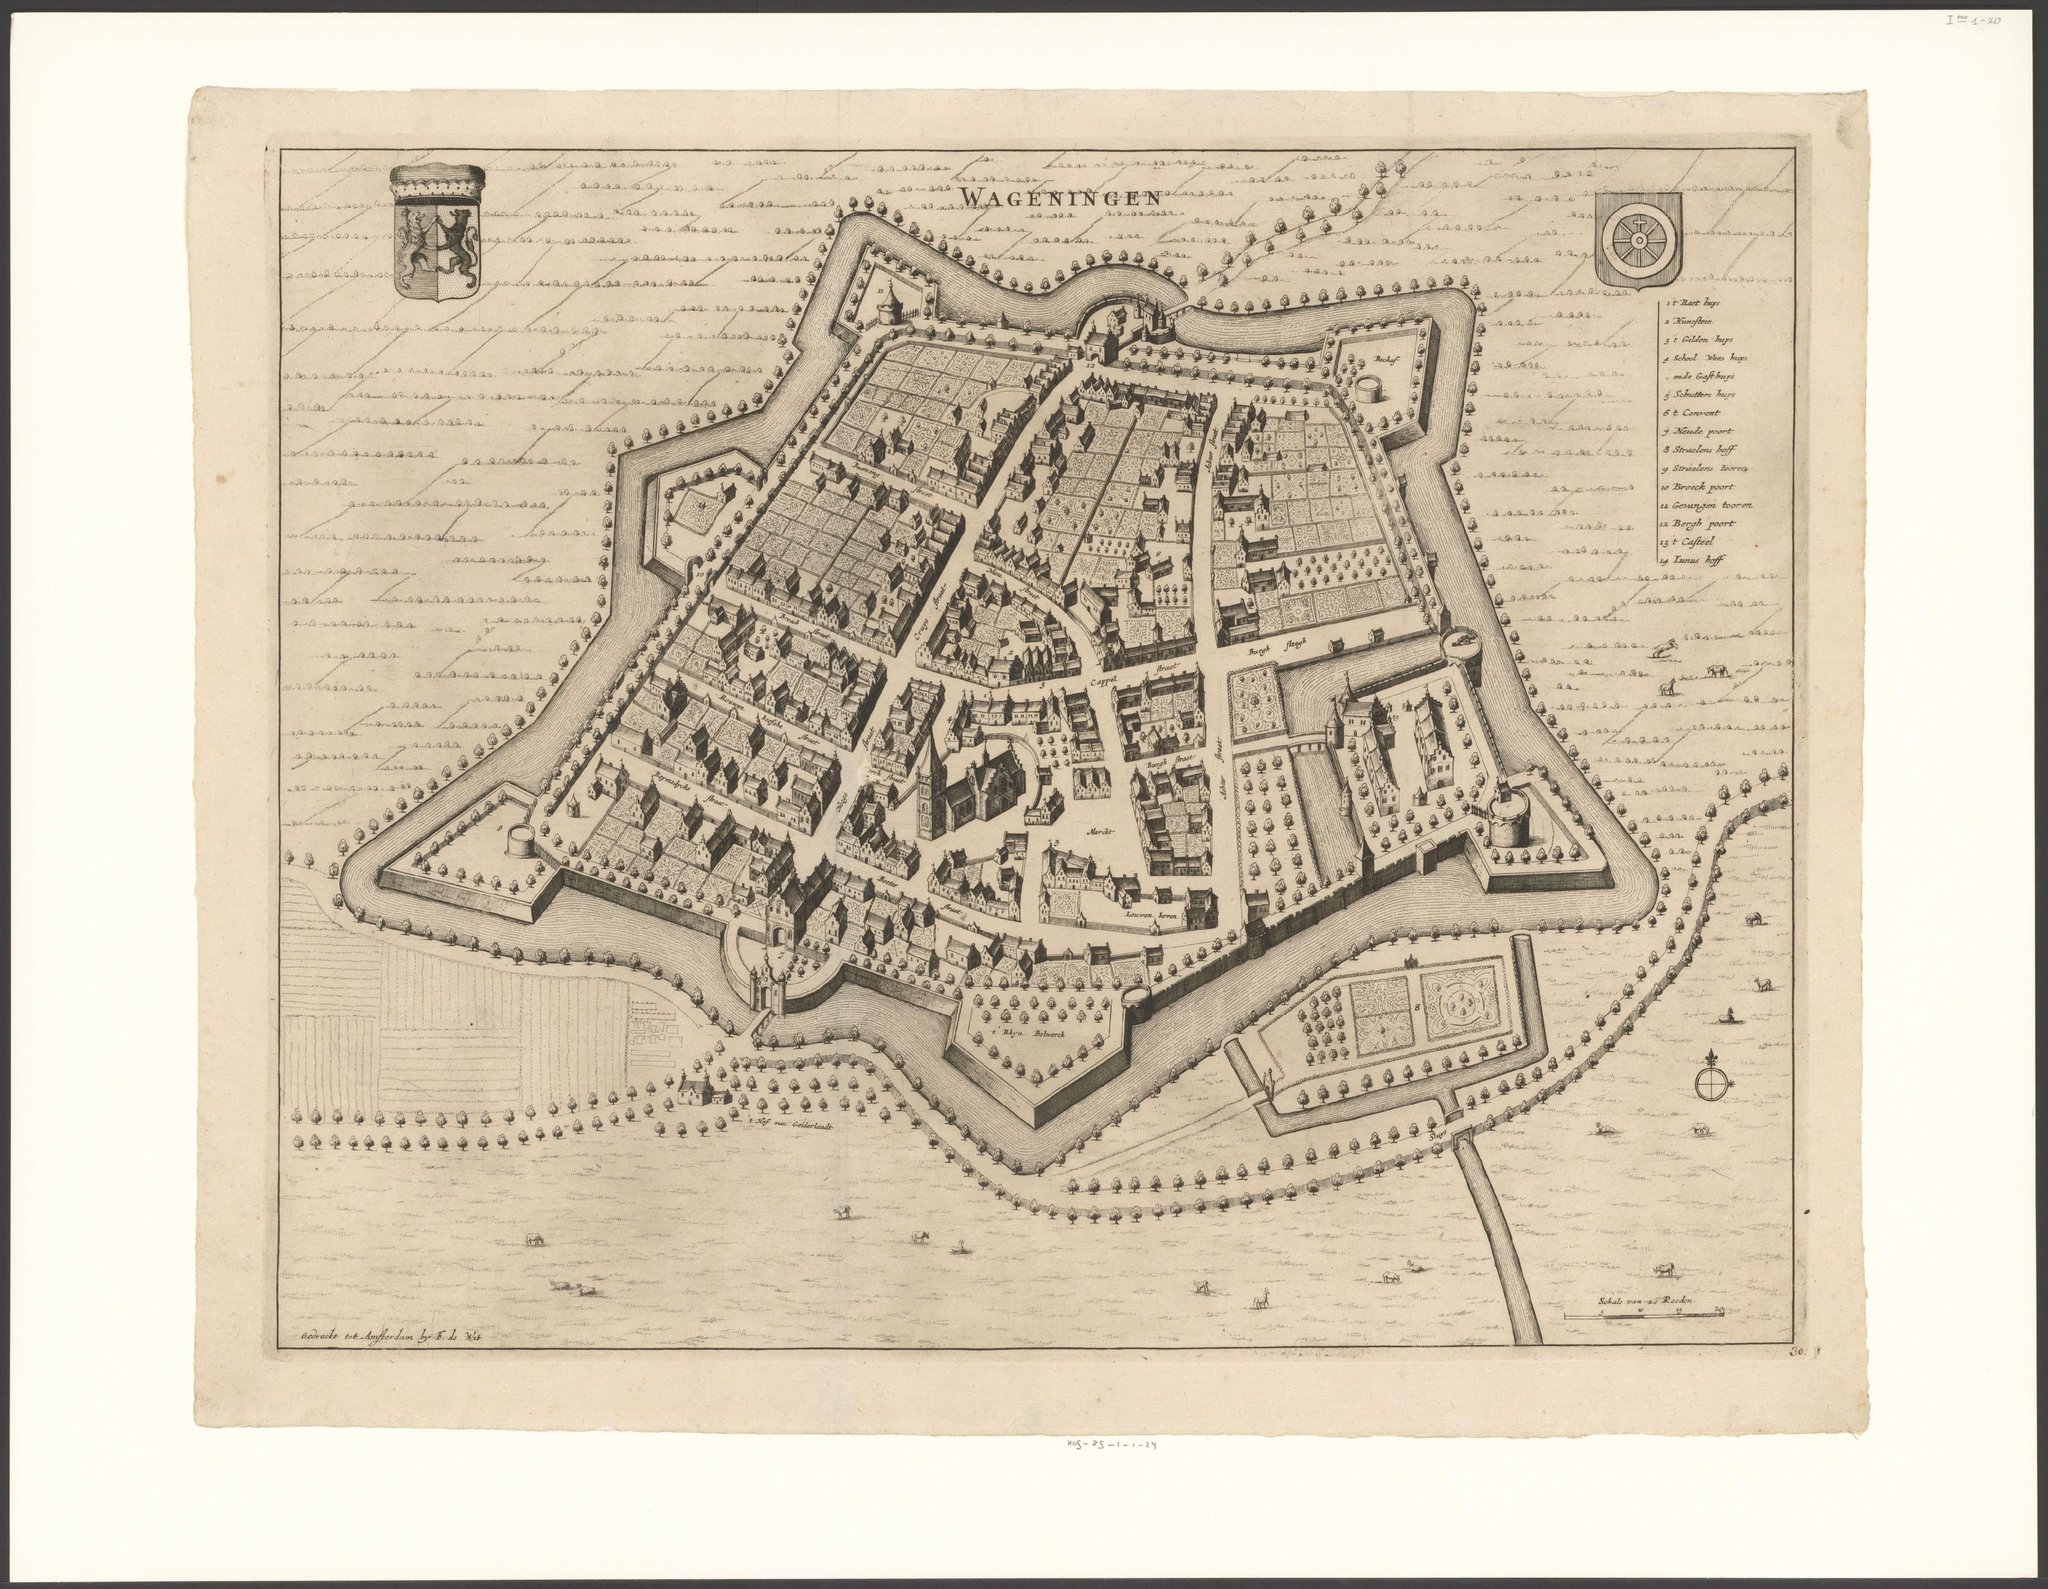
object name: area plan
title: Wageningen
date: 1700-1710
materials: paper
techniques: engraving, etching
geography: amsterdam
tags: maps of cities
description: Plattegrond van de stad Wageningen. Linksboven het wapen van het hertogdom Gelre, rechtsboven het stadswapen. Rechts de legenda 1-14, rechtsonder een kompasroos en schaalstok. Onderwerpsrubrieken binnen de Atlas Zeden en Gewoonten: topografie; stadsplattegronden.